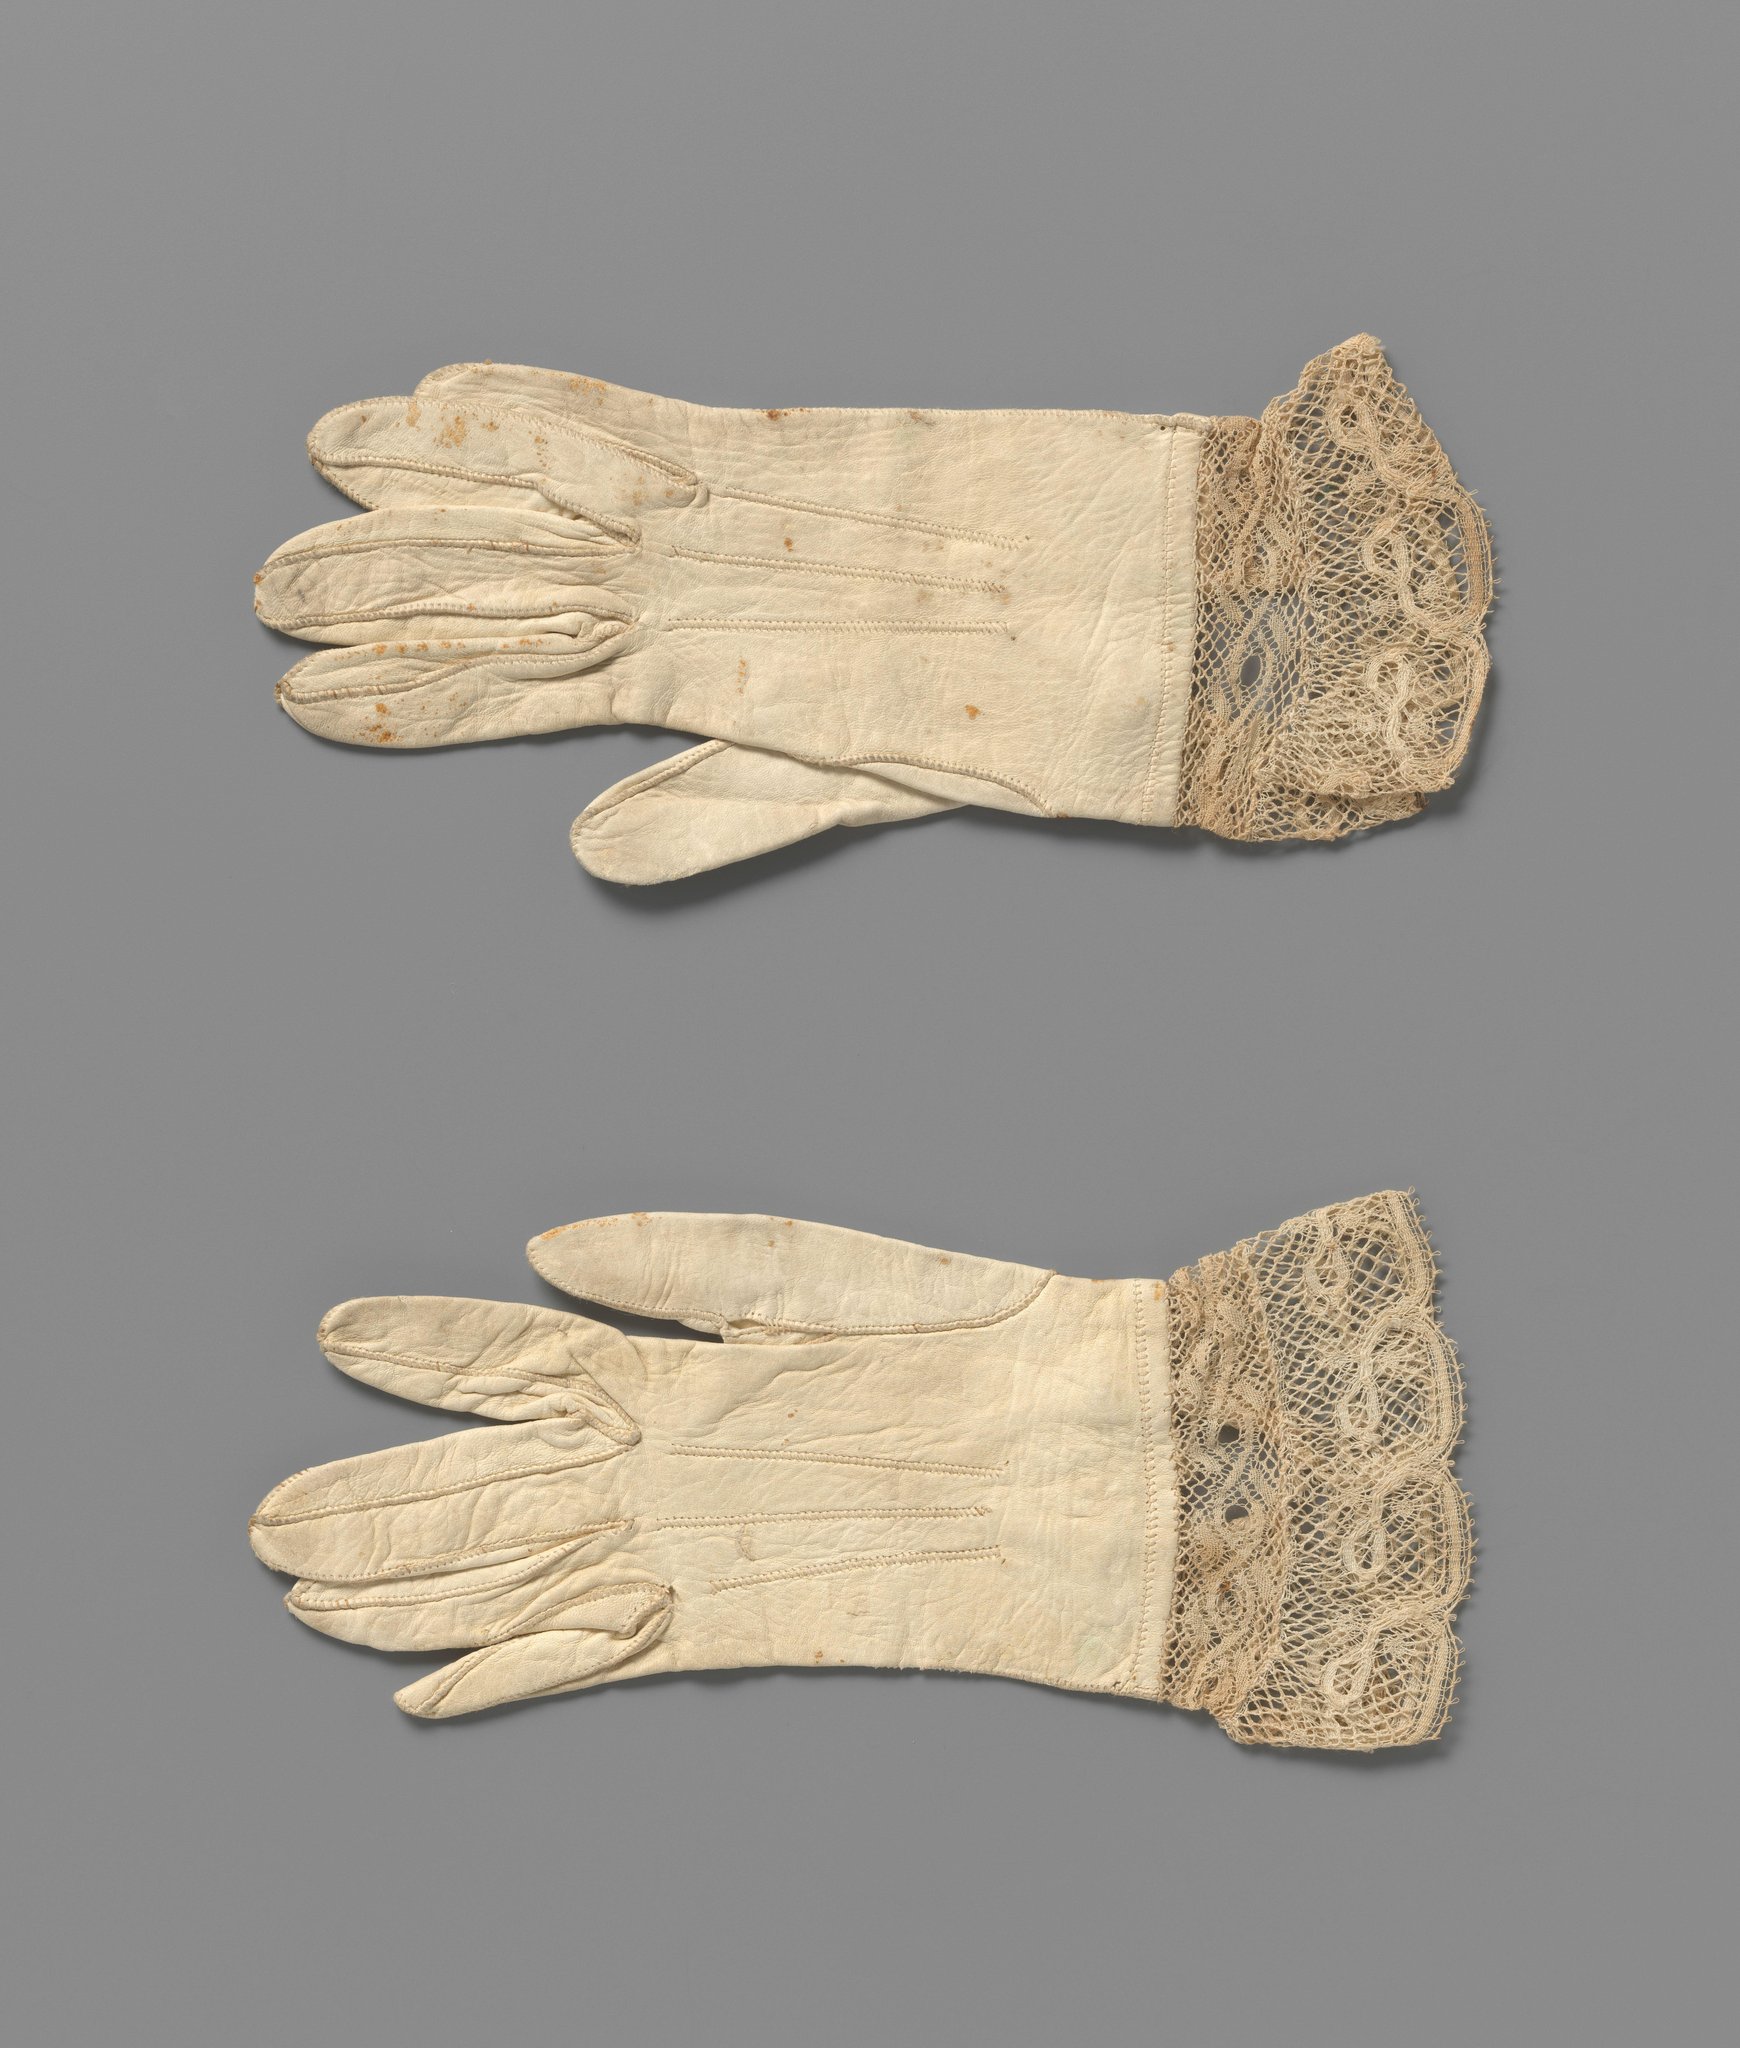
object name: childrenswear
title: Linkerkinderhandschoen van wit glacéleer met opslagen van machinale kant: imitatie Valenciennes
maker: Anonymous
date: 1900-1910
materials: glazing, lace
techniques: lace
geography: netherlands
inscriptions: inscription: ‘4 1/4’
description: Linkerkinderhandschoen van wit glacéleer met opslagen van machinale kant: imitatie Valenciennes. Kort model, knoopsluiting.